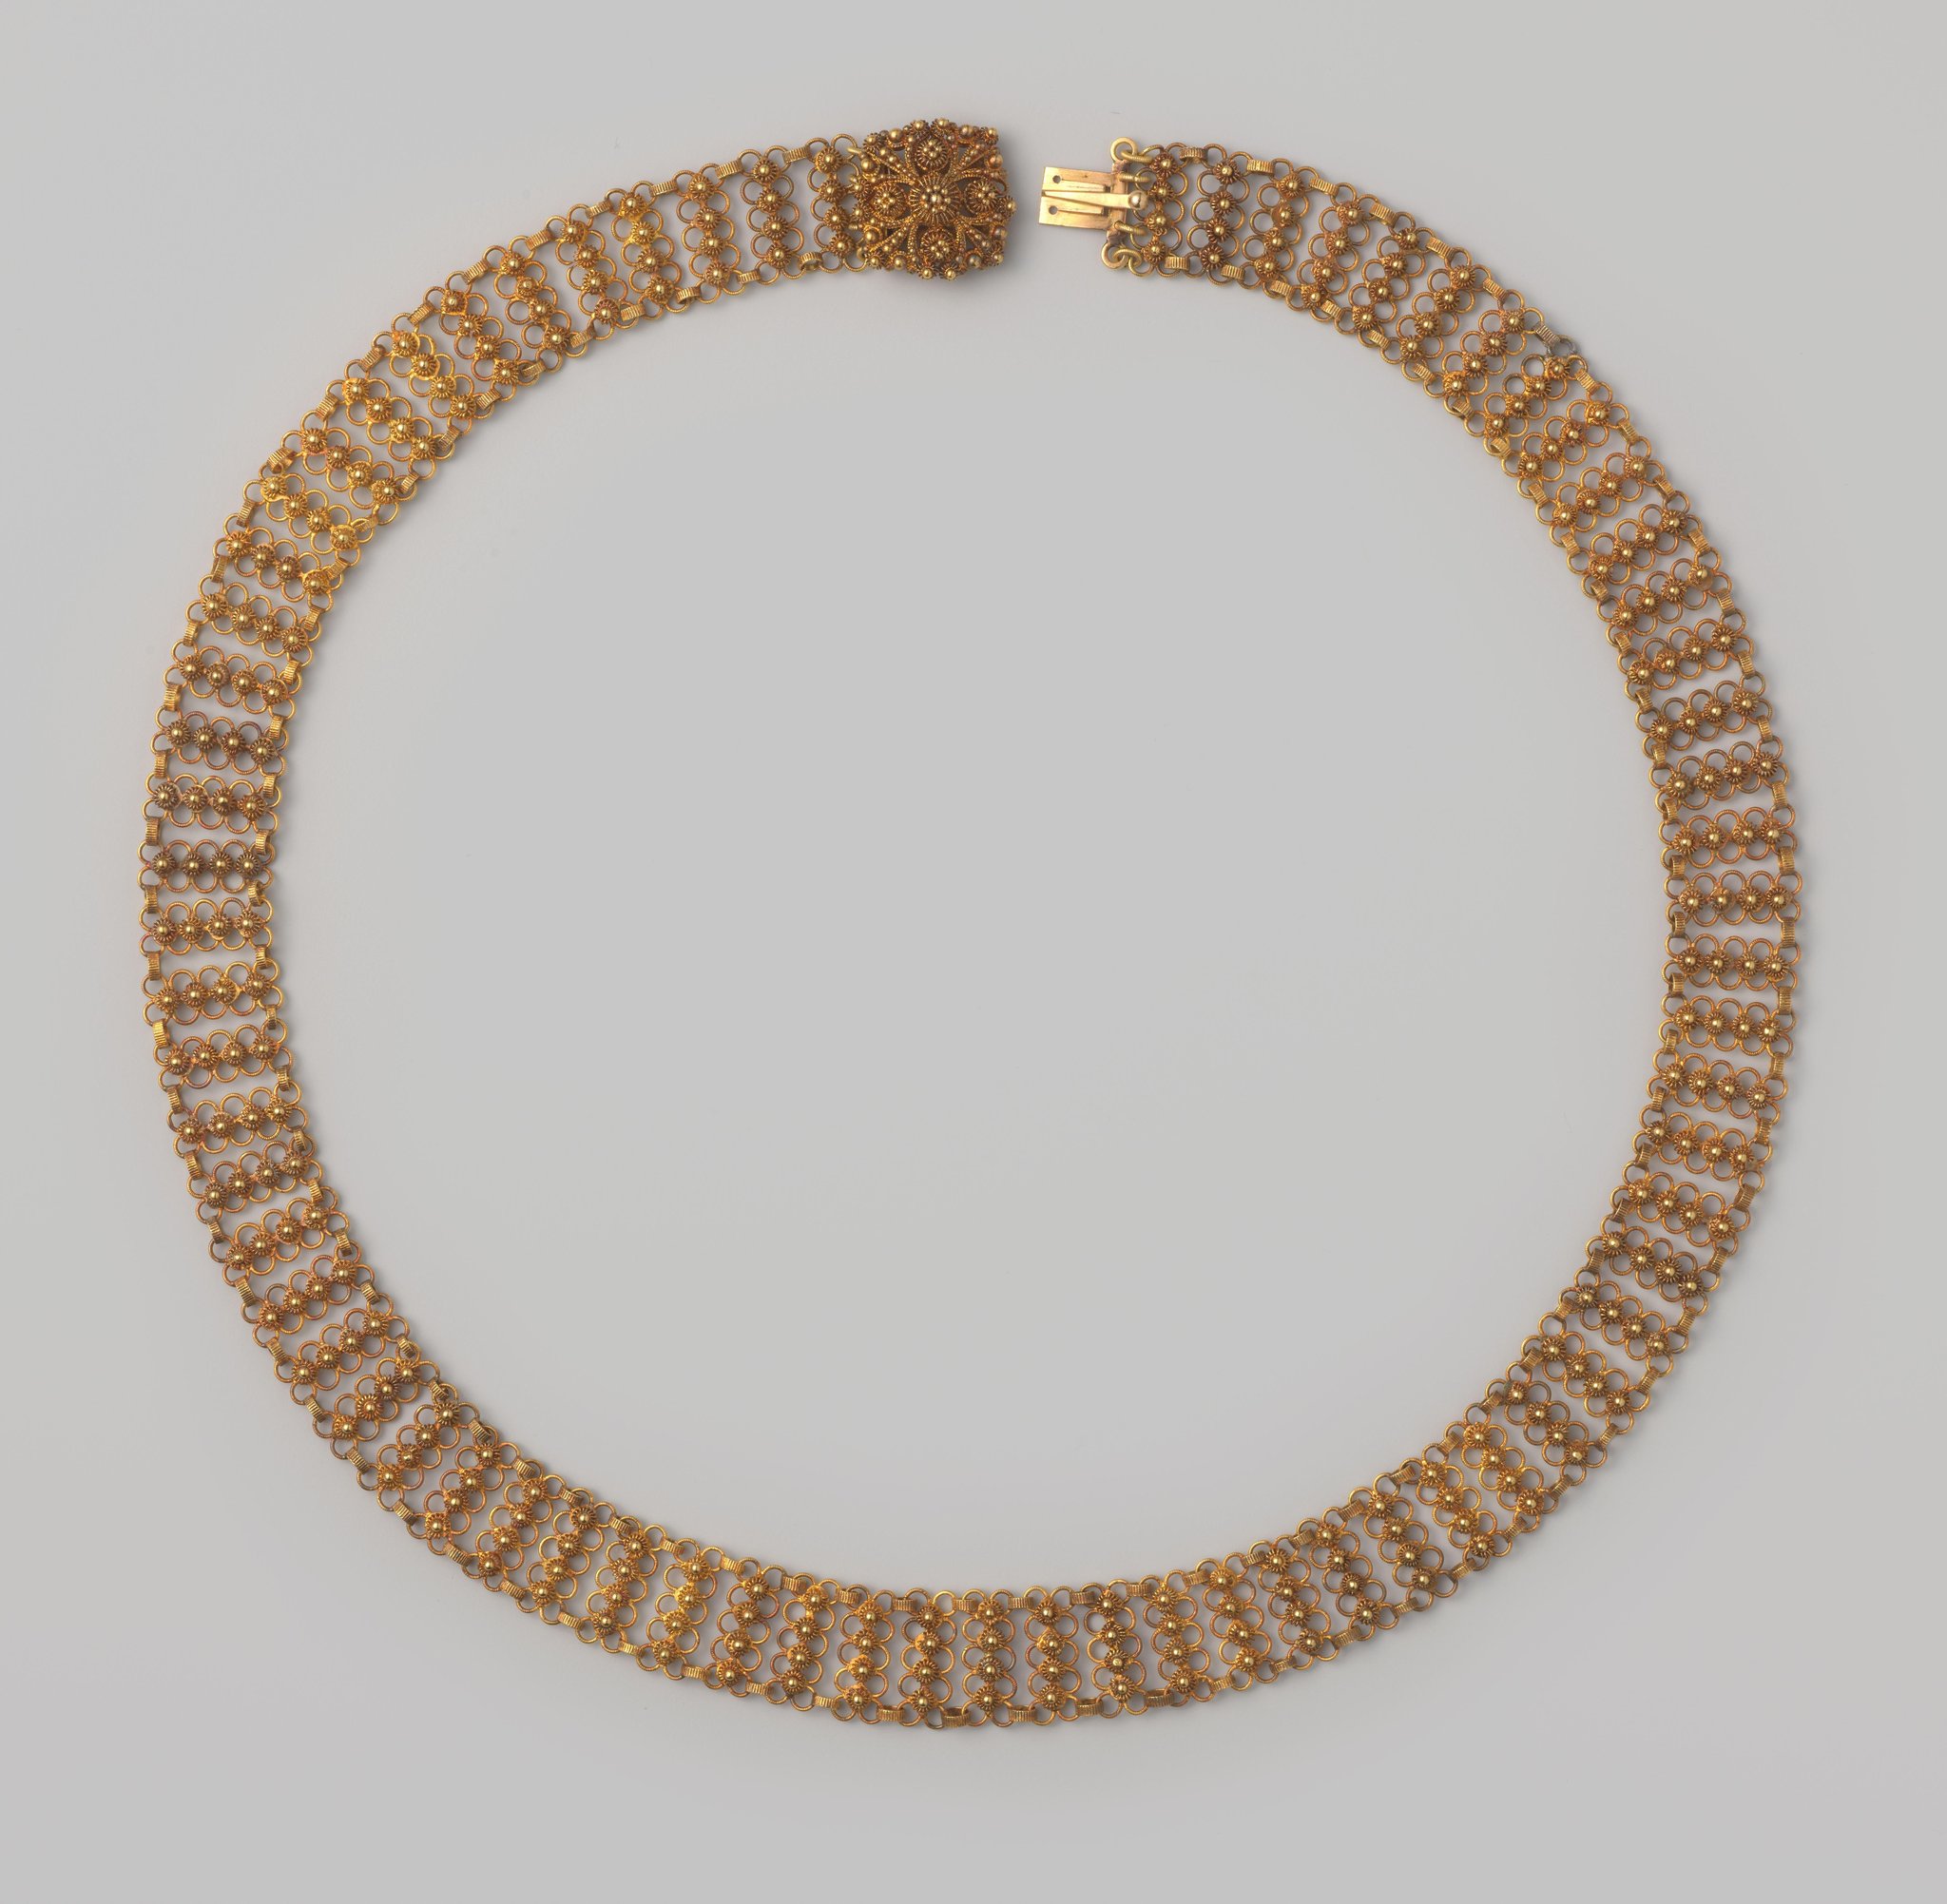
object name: necklace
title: Collier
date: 1835-1837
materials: gold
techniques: filigree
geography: amsterdam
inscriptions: maker's mark: ‘W&S’, alloy mark: ‘leeuwenkop’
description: Parure van goud in filigreintechniek, in rood leren foedraal. Bestaande uit: diadeem, halssnoer, twee armbanden en twee oorknoppen. Het foedraal is met witte zijde gevoerd.